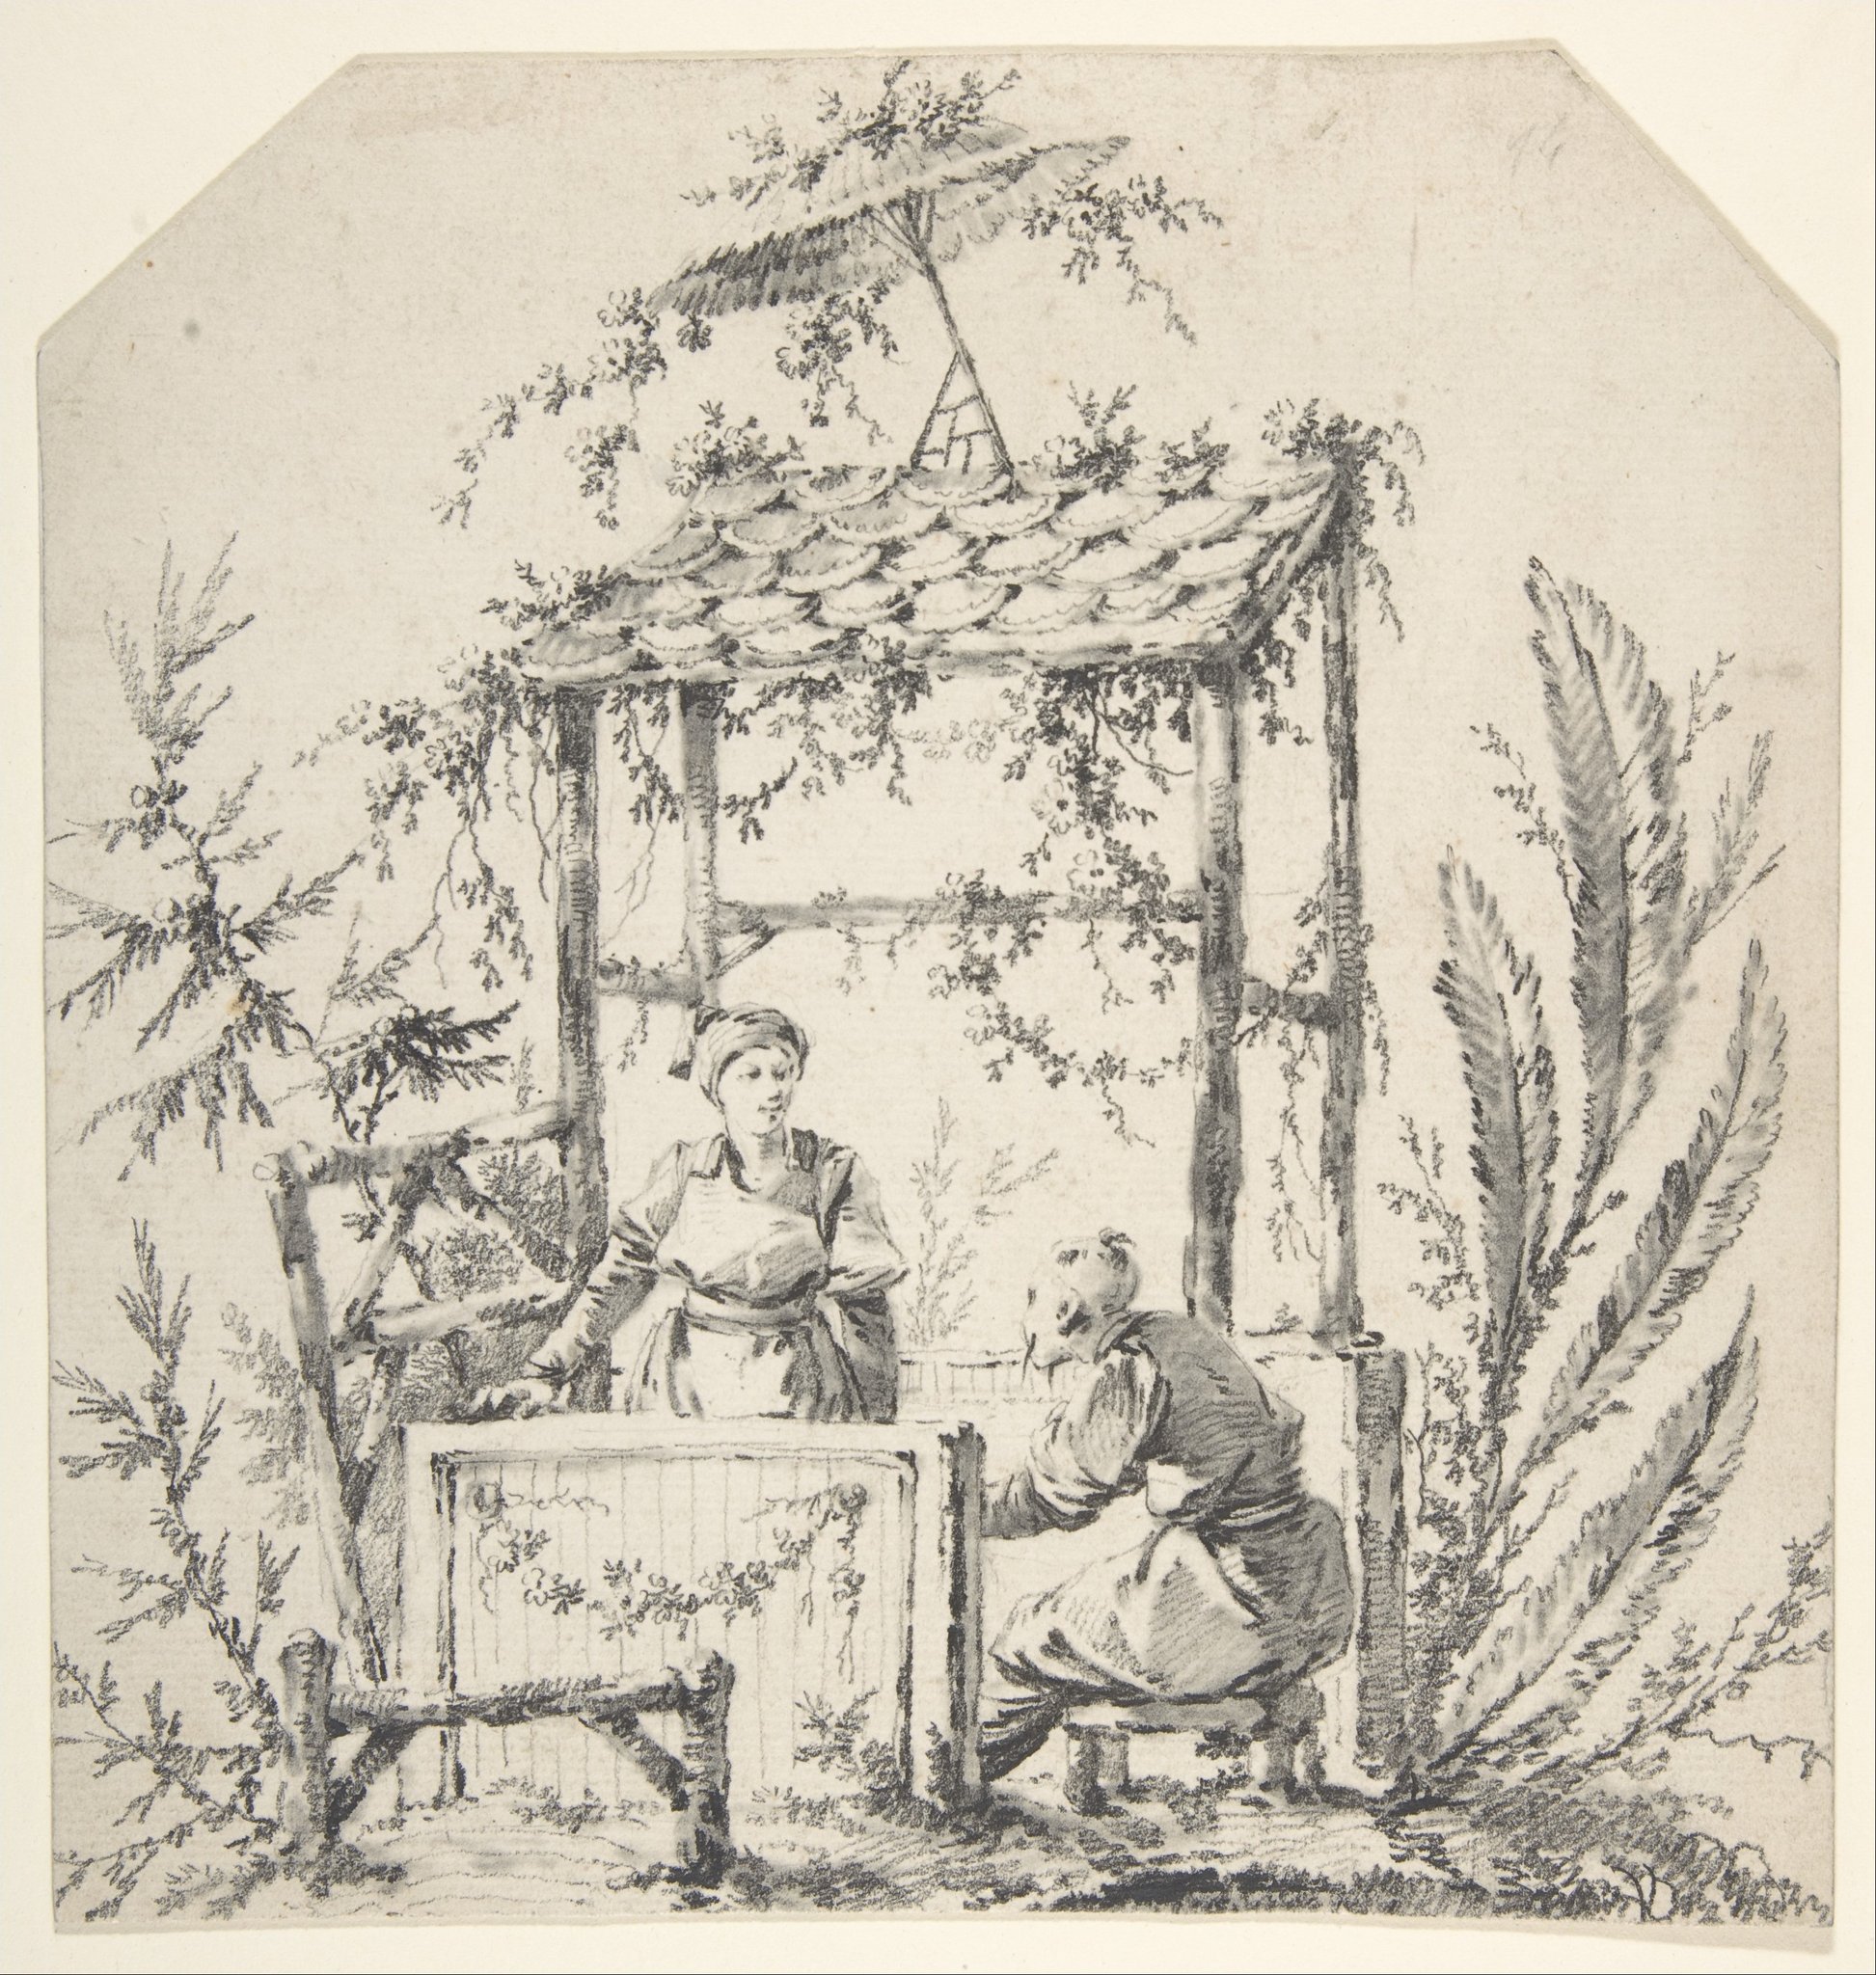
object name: drawing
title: Chinoiserie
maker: jean pillement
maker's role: artist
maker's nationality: french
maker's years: 1728-1808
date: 1728-1808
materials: chalk, graphite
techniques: stumping, wash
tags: chinoiserie,men,women,trees